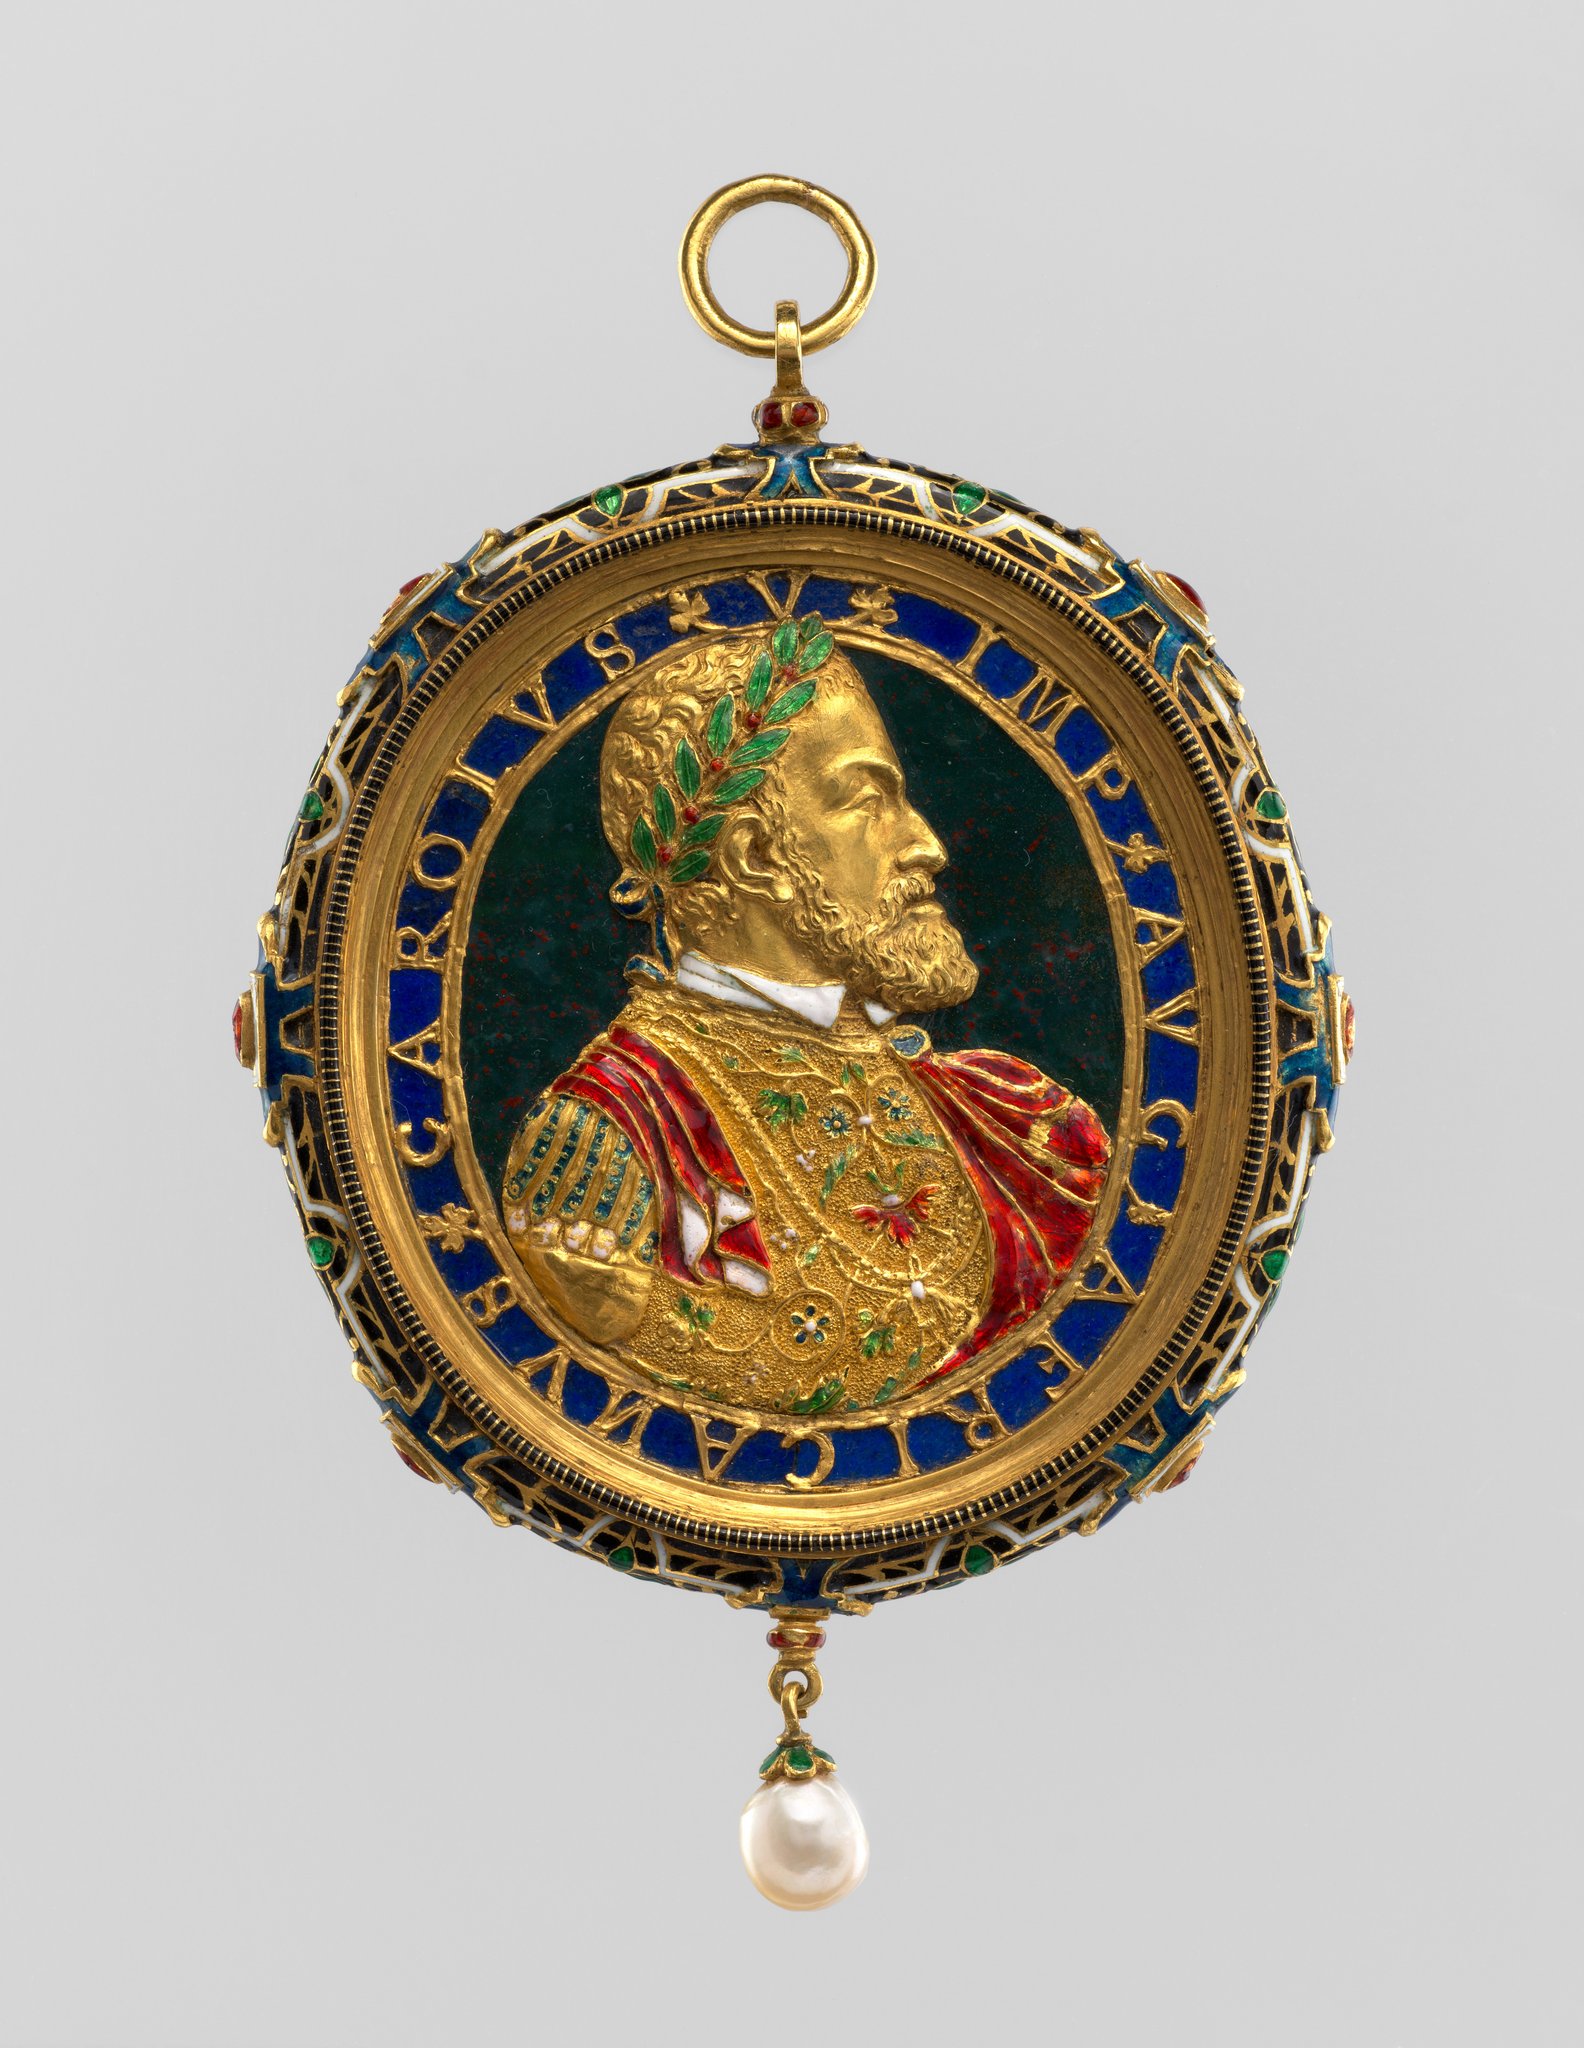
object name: medallion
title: Emperor Charles V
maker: alfred andré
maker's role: maker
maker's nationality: french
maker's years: 1839-1919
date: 1876-1900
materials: enamel, gold, lapis lazuli, pearl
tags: men,profiles